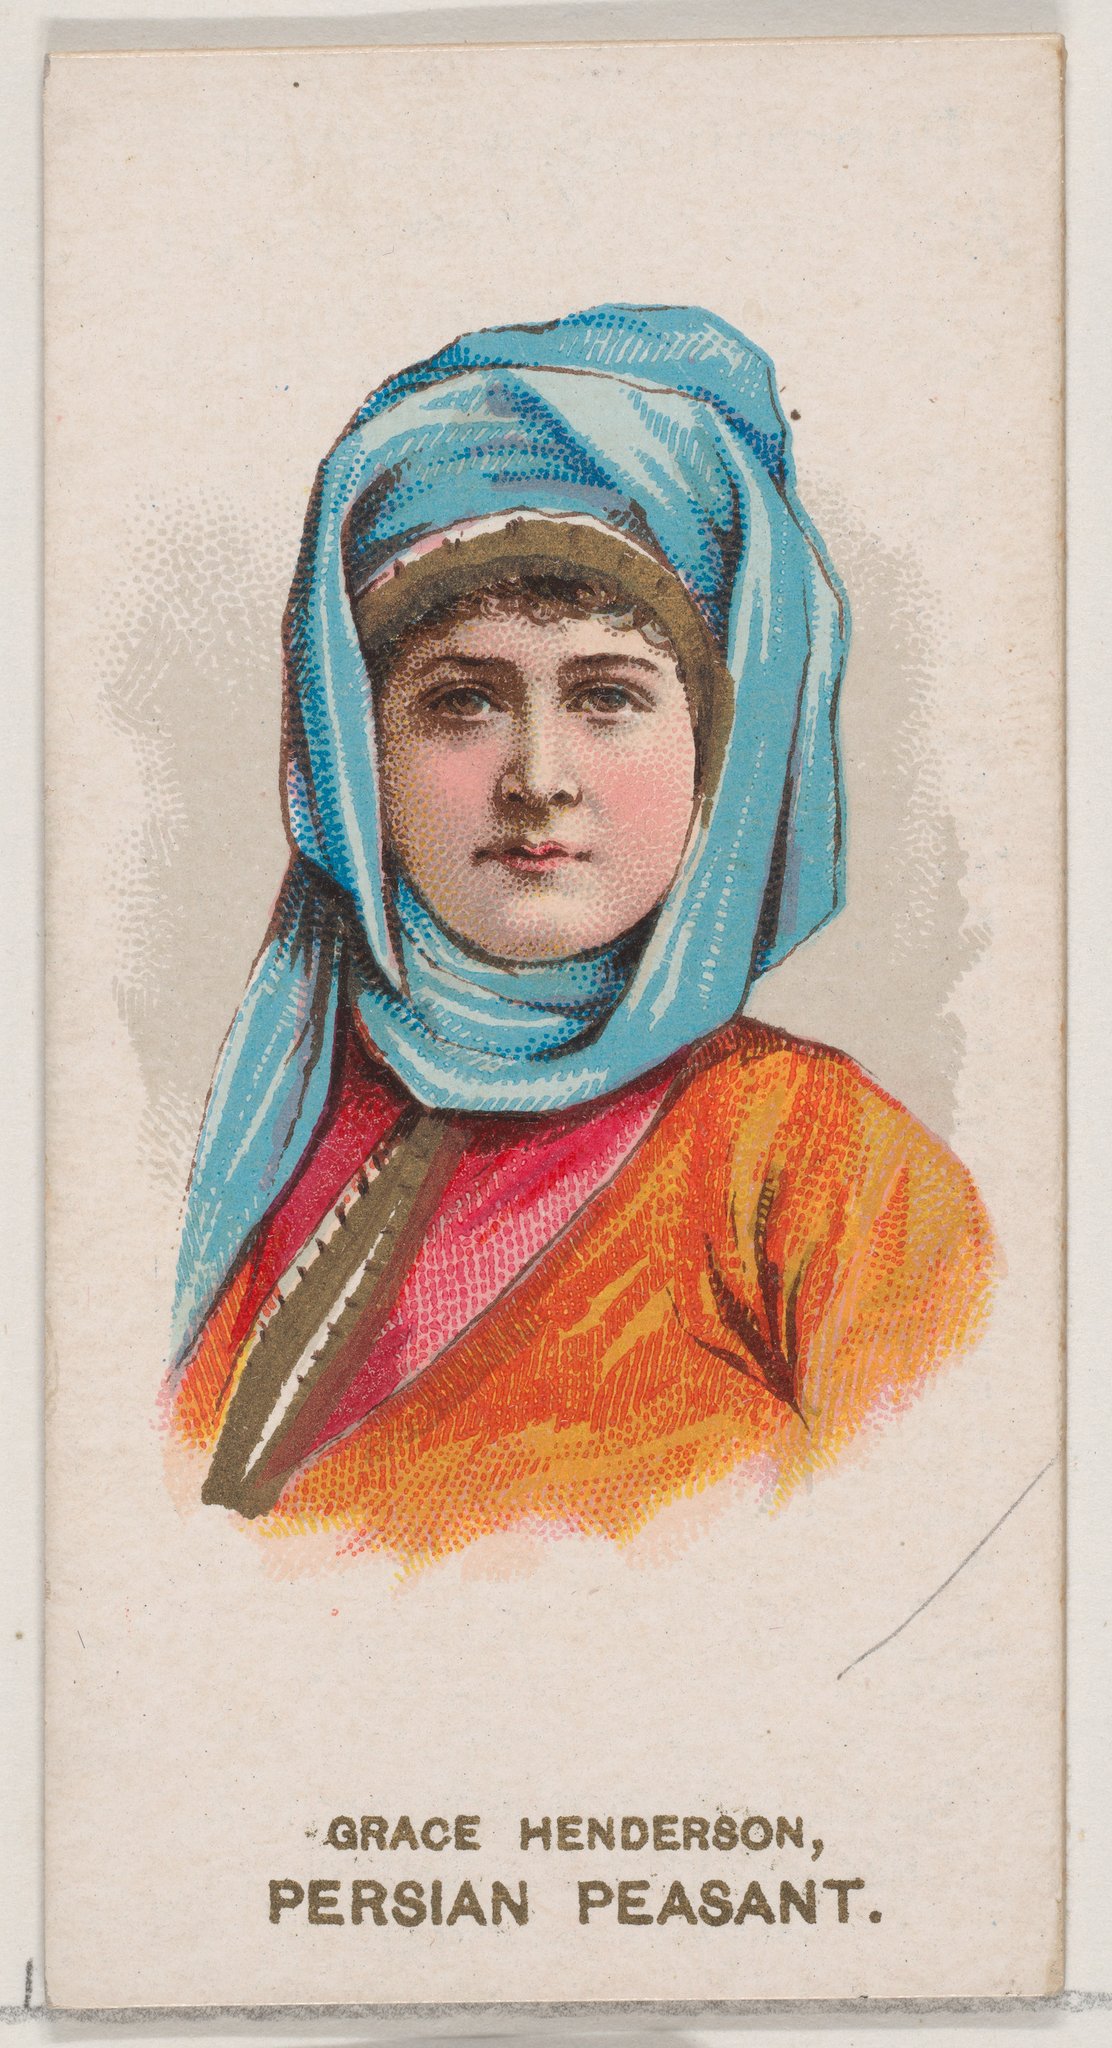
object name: print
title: Grace Henderson Dressed as Persian Peasant, from the set Actors and Actresses, Second Series (N71) for Duke brand cigarettes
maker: w. duke, sons & co.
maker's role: publisher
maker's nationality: american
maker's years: 1870-1920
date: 1888-1890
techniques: color lithograph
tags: women,actresses